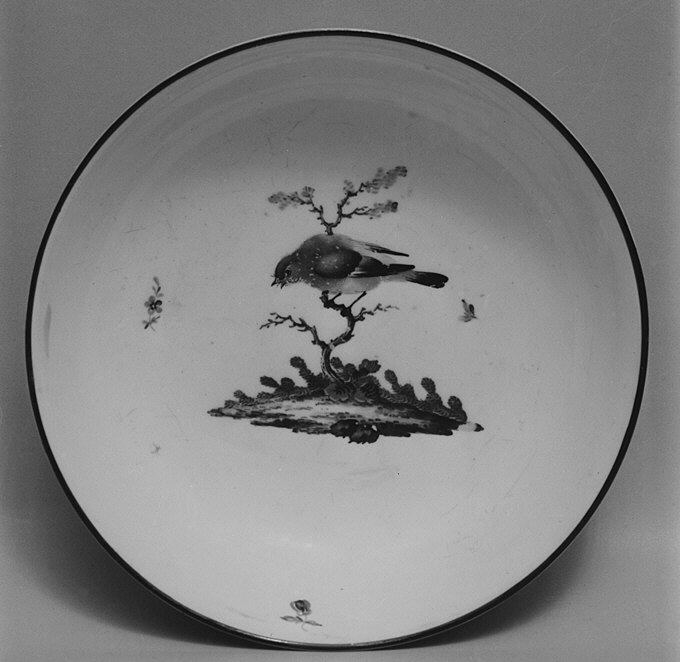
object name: saucer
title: Saucer (part of a service)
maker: frankenthal porcelain manufactory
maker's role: manufactory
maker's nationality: german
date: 1770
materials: hard paste porcelain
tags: birds,trees